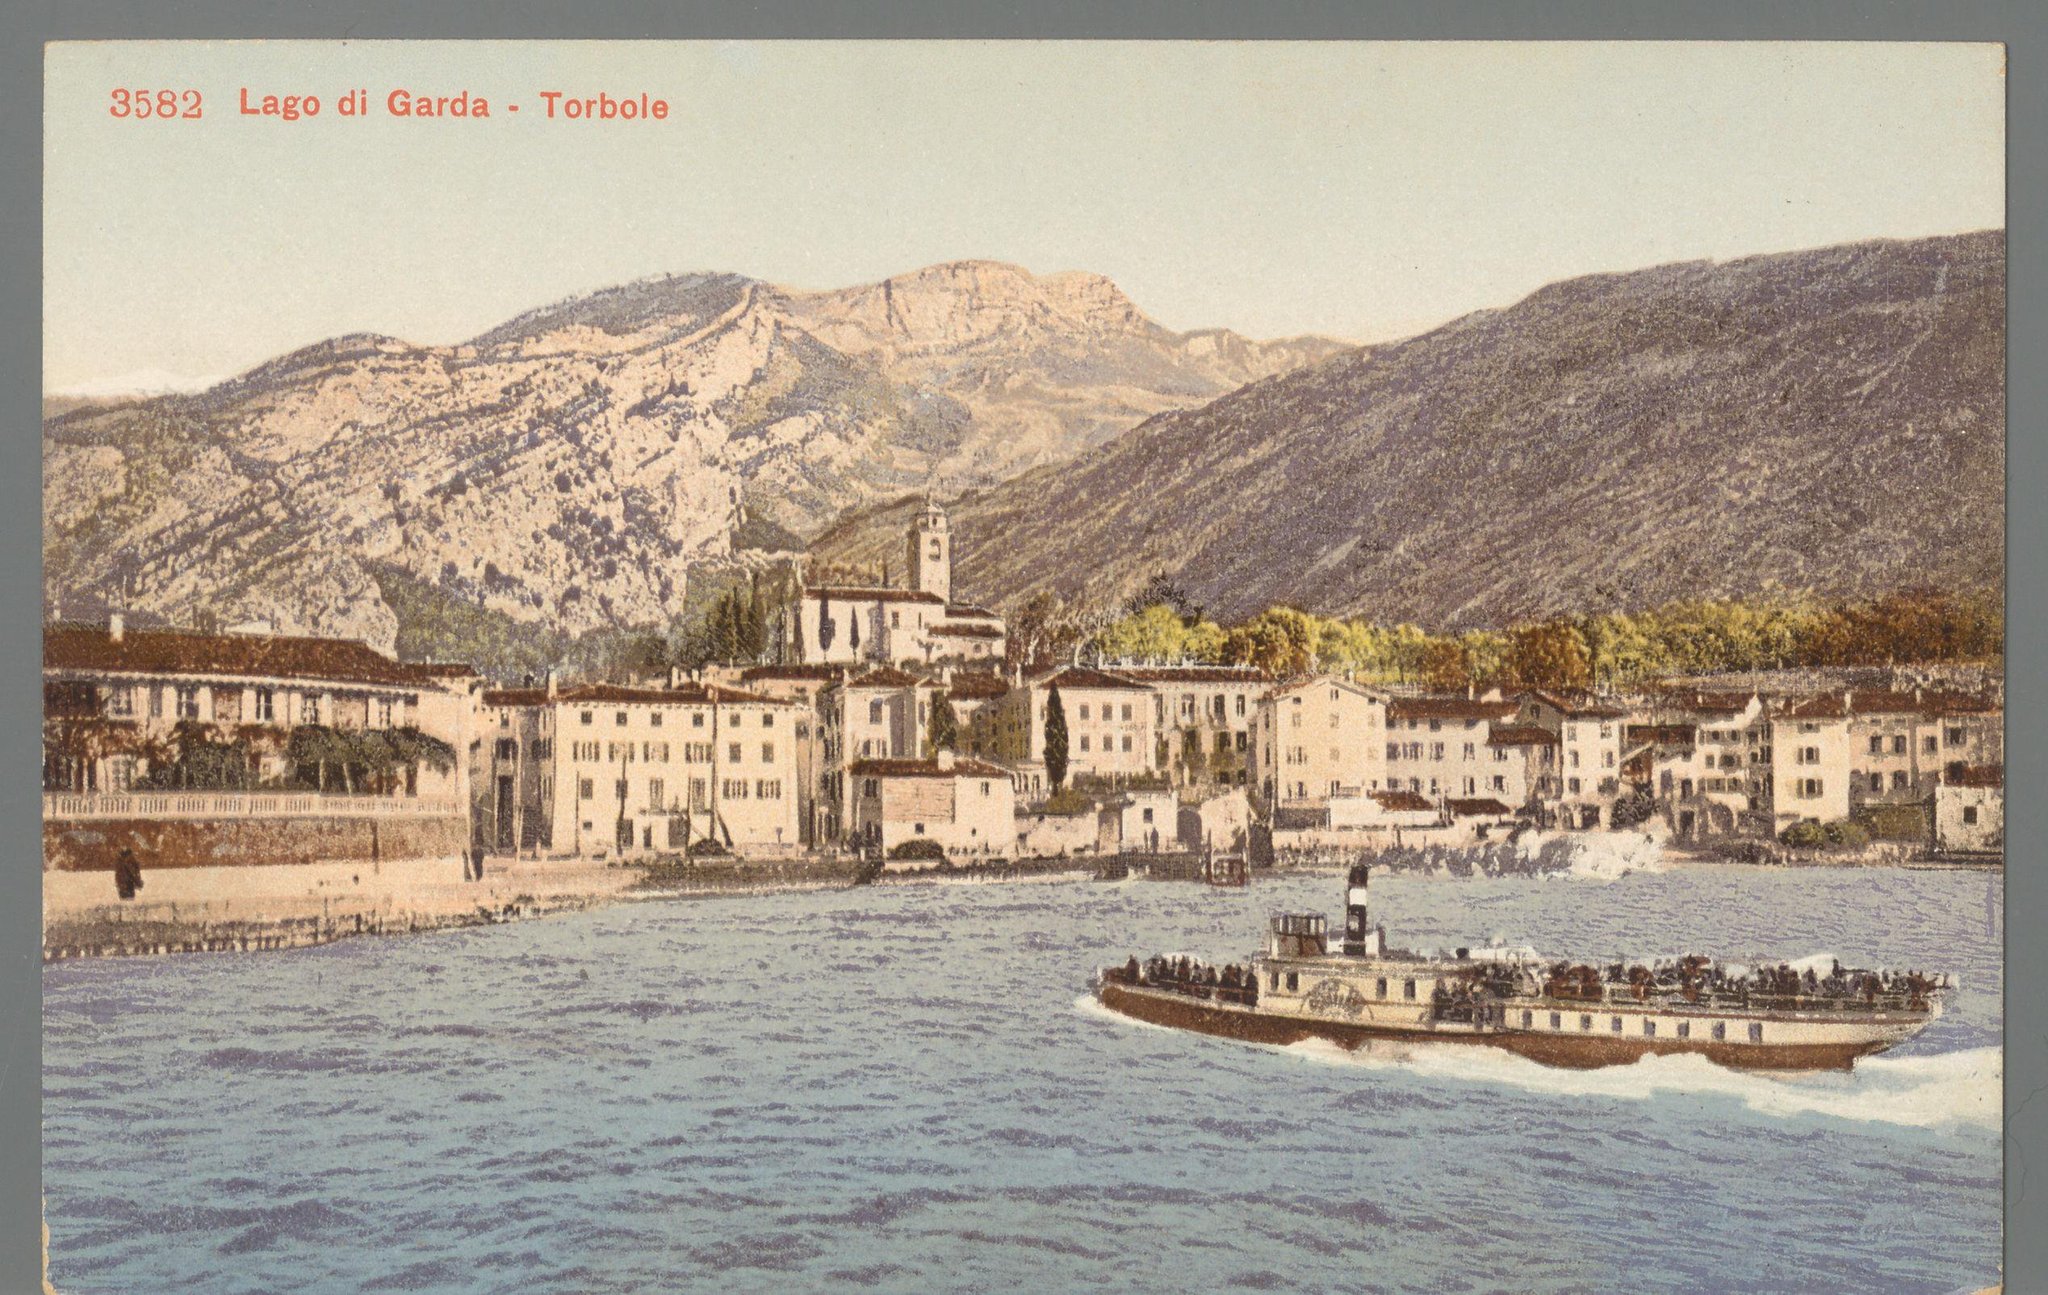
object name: photomechanical print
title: Lago di Garda. Torbole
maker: Anonymous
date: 1905-1930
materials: cardboard, photographic process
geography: zurich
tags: prospect of village, silhouette of village, lake, mountains